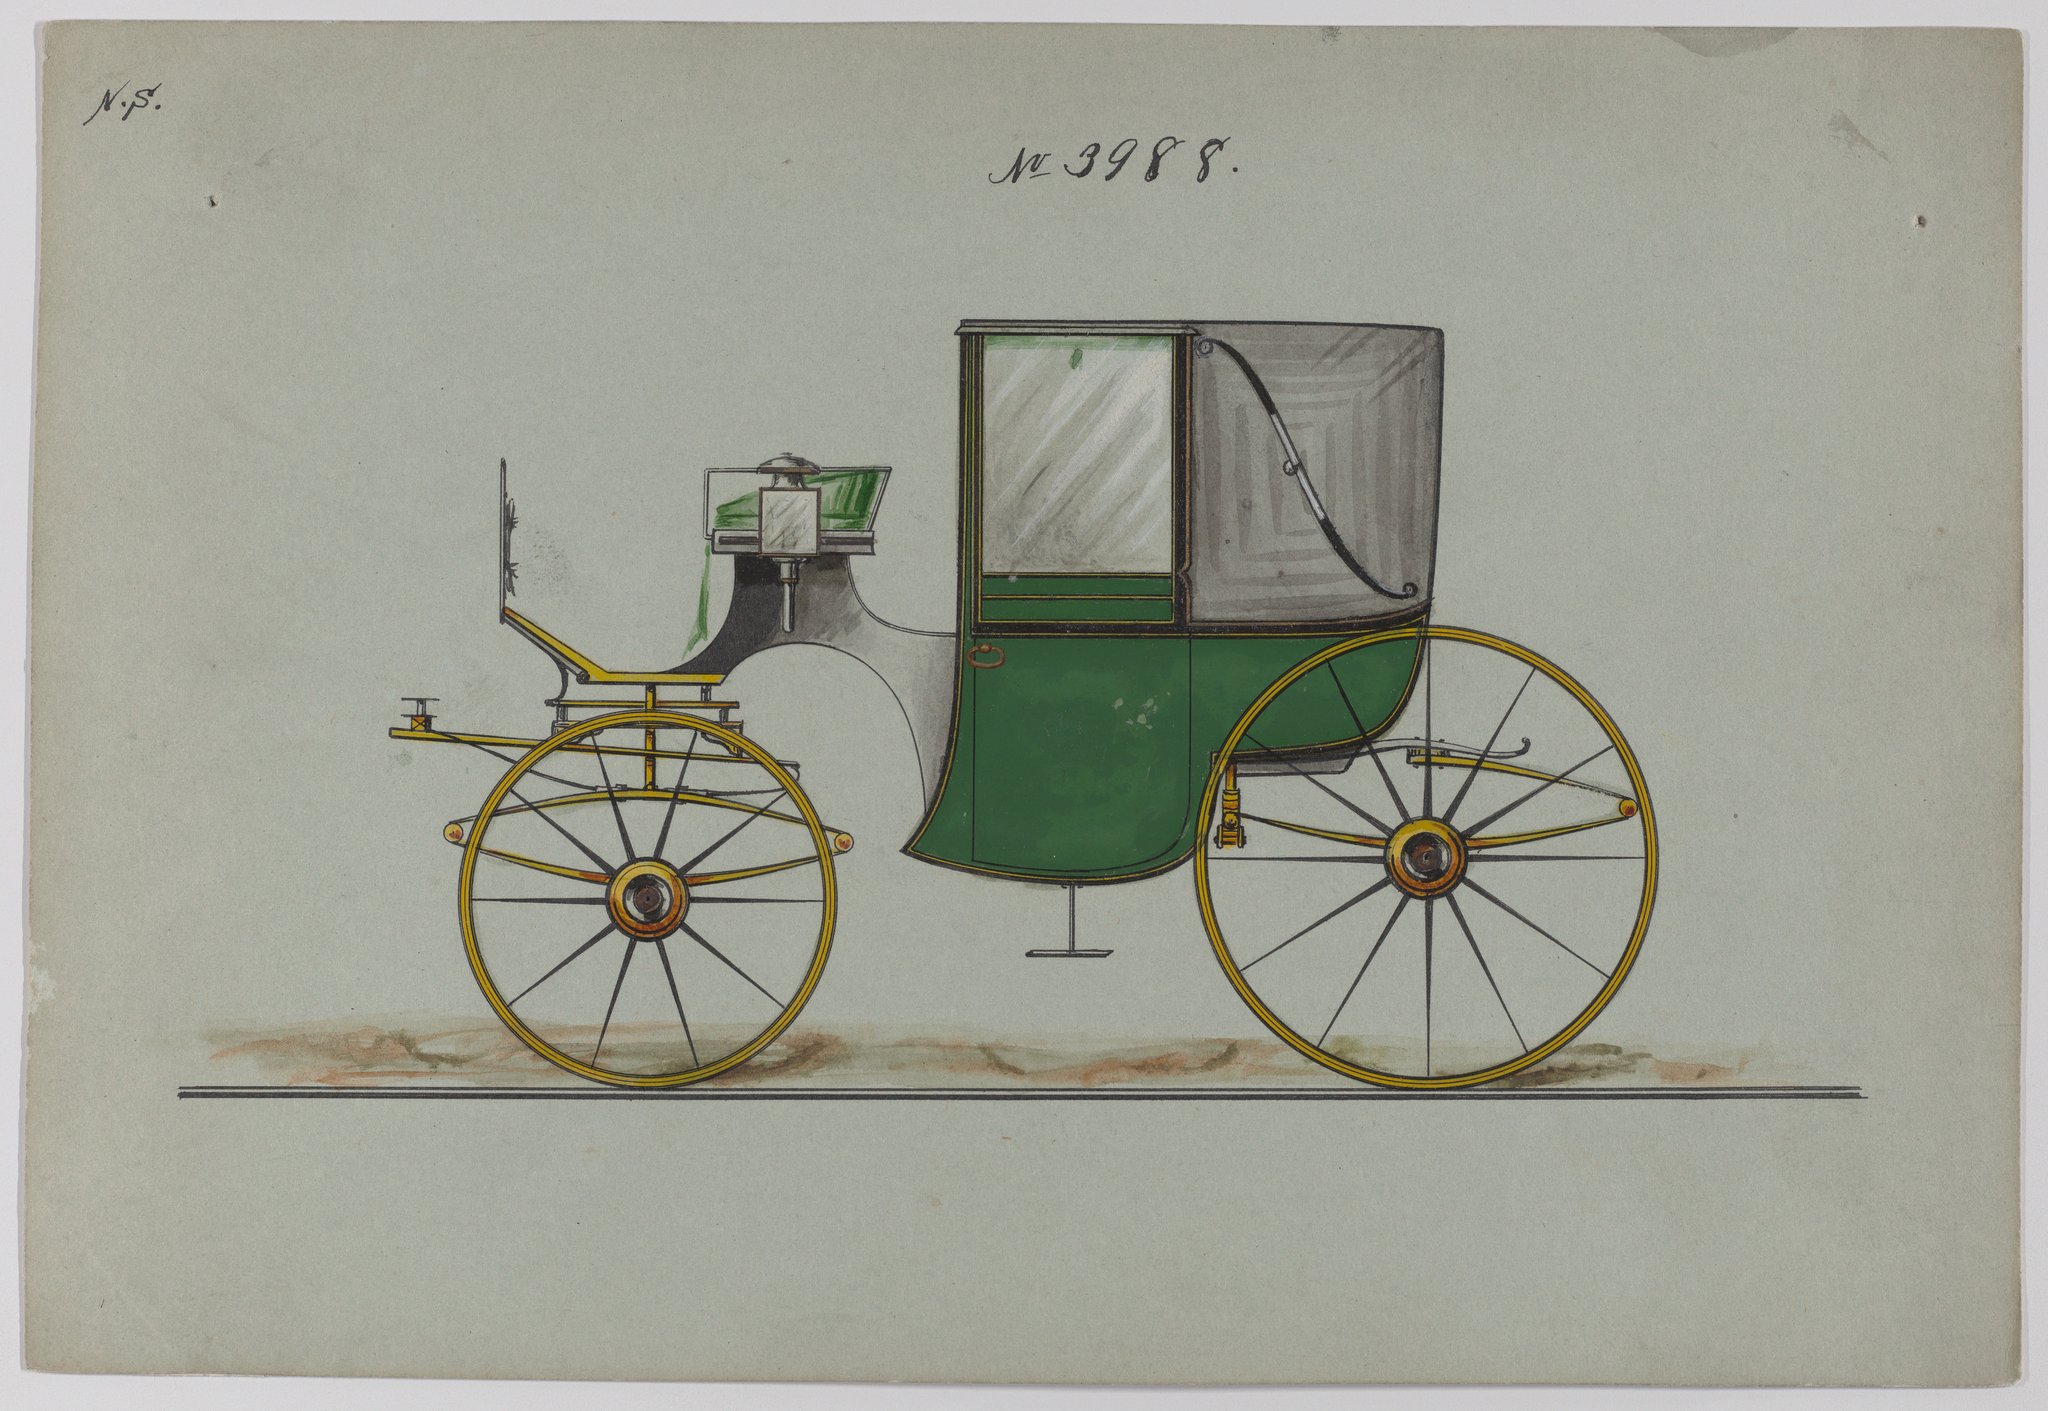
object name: drawing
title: Design for Brougham, no. 3988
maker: brewster & co.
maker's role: manufacturer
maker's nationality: american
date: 1887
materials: gouache, gum arabic, ink, watercolor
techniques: pen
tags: carriages